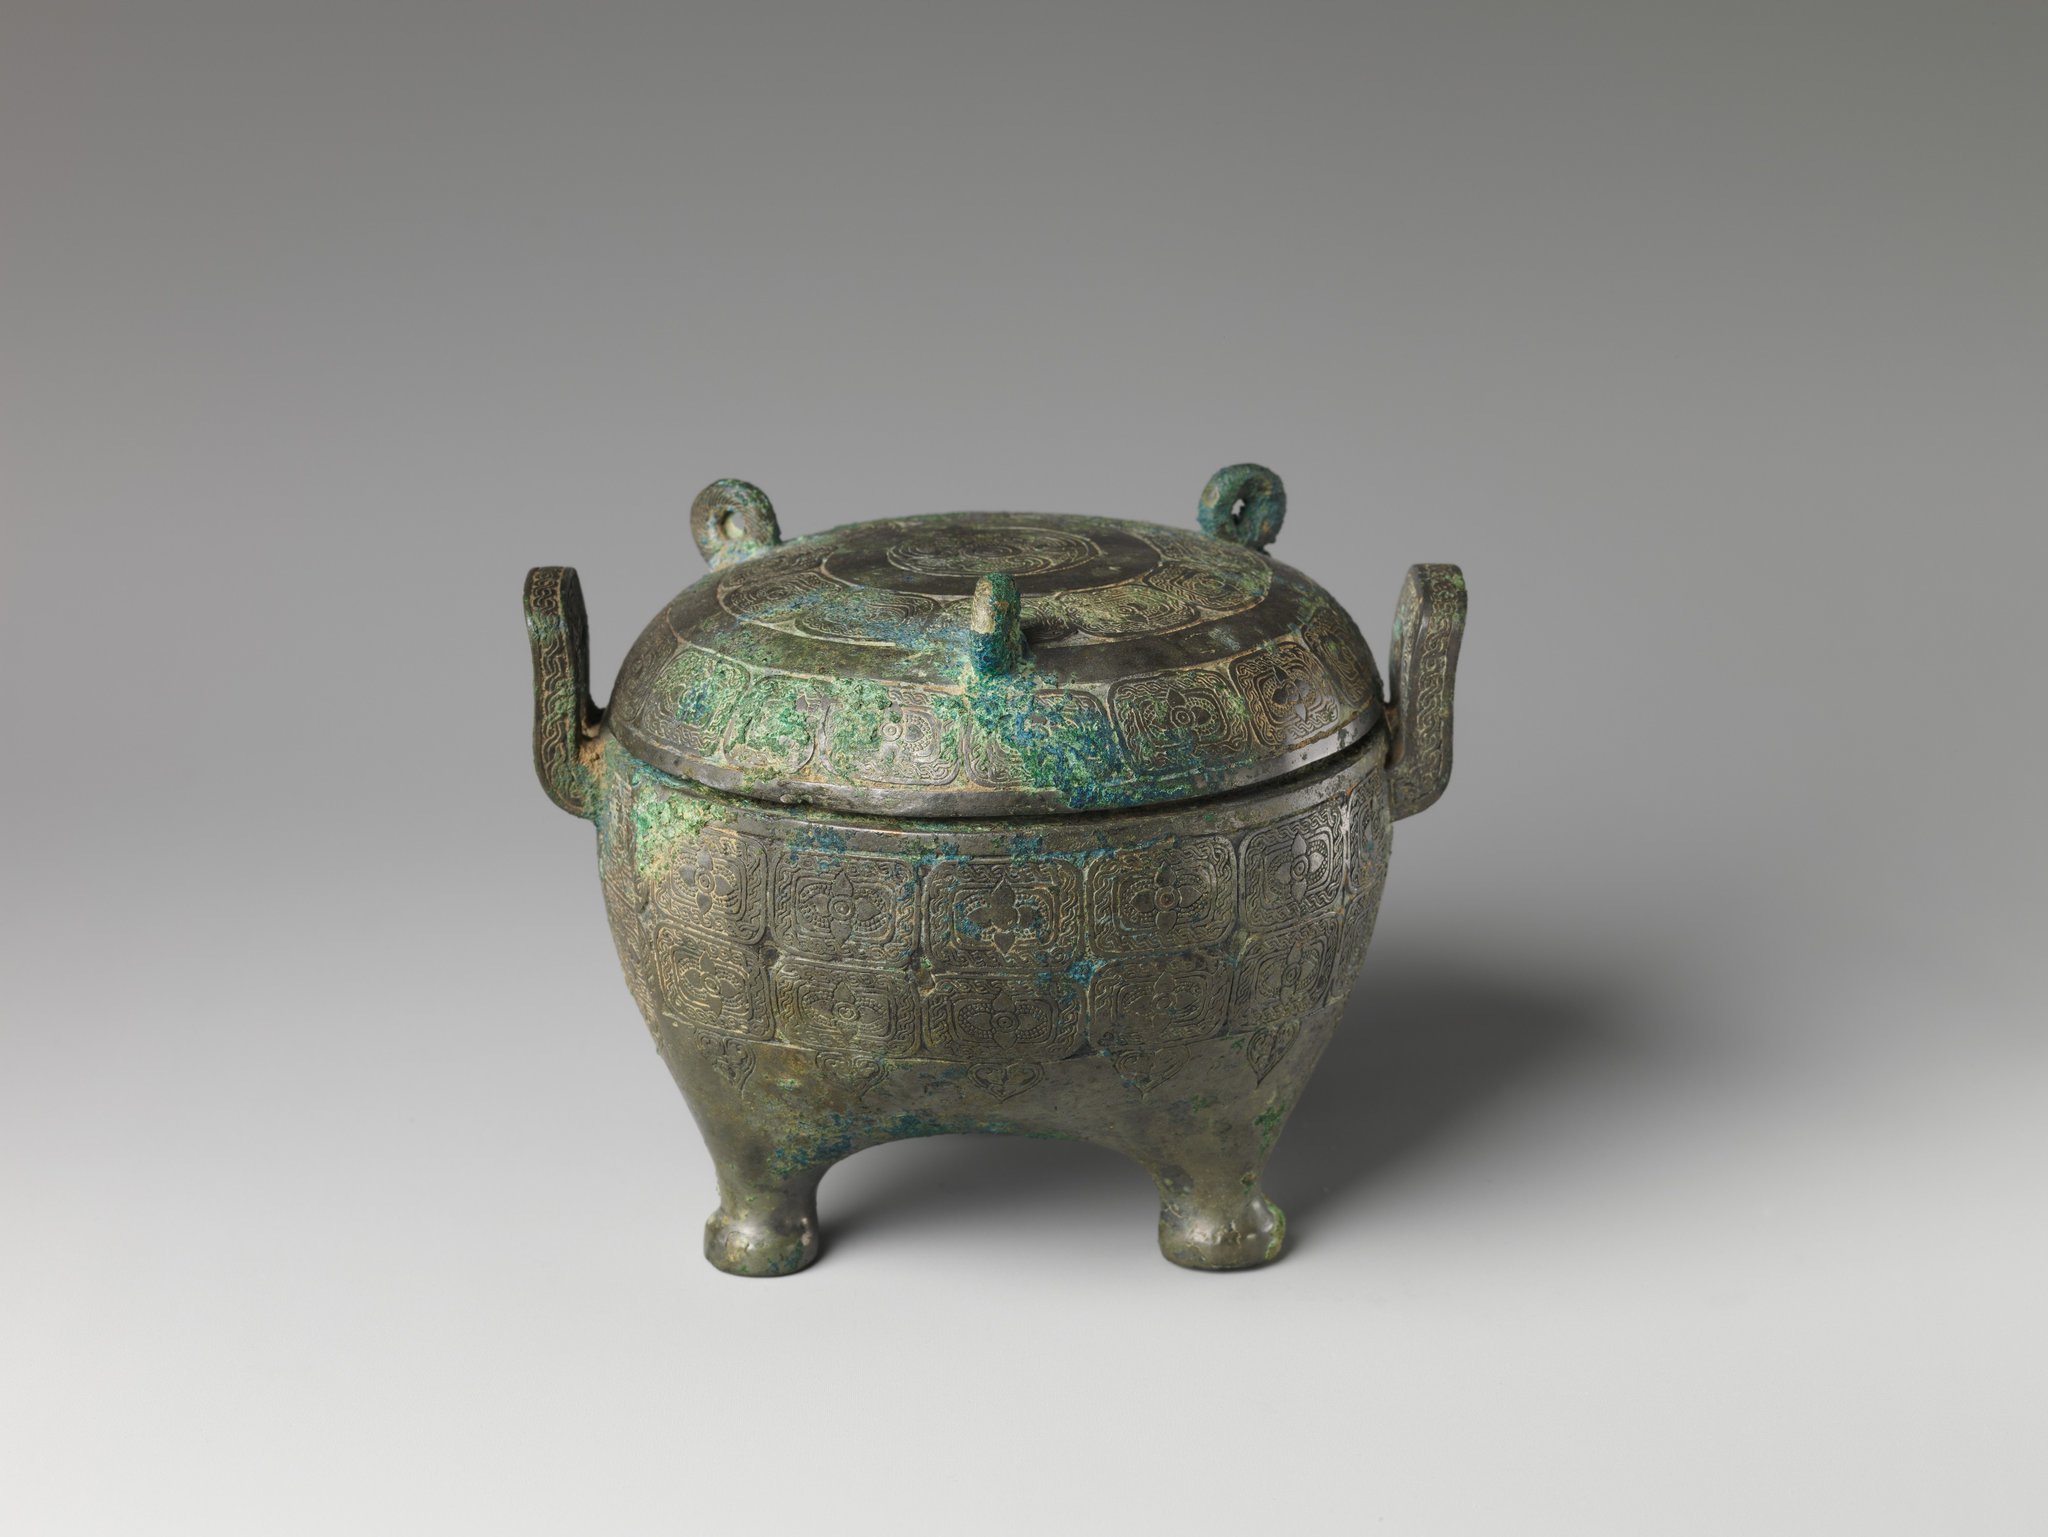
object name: grain vessel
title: Grain serving vessel (dui)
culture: chinese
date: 500-401 BCE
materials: bronze